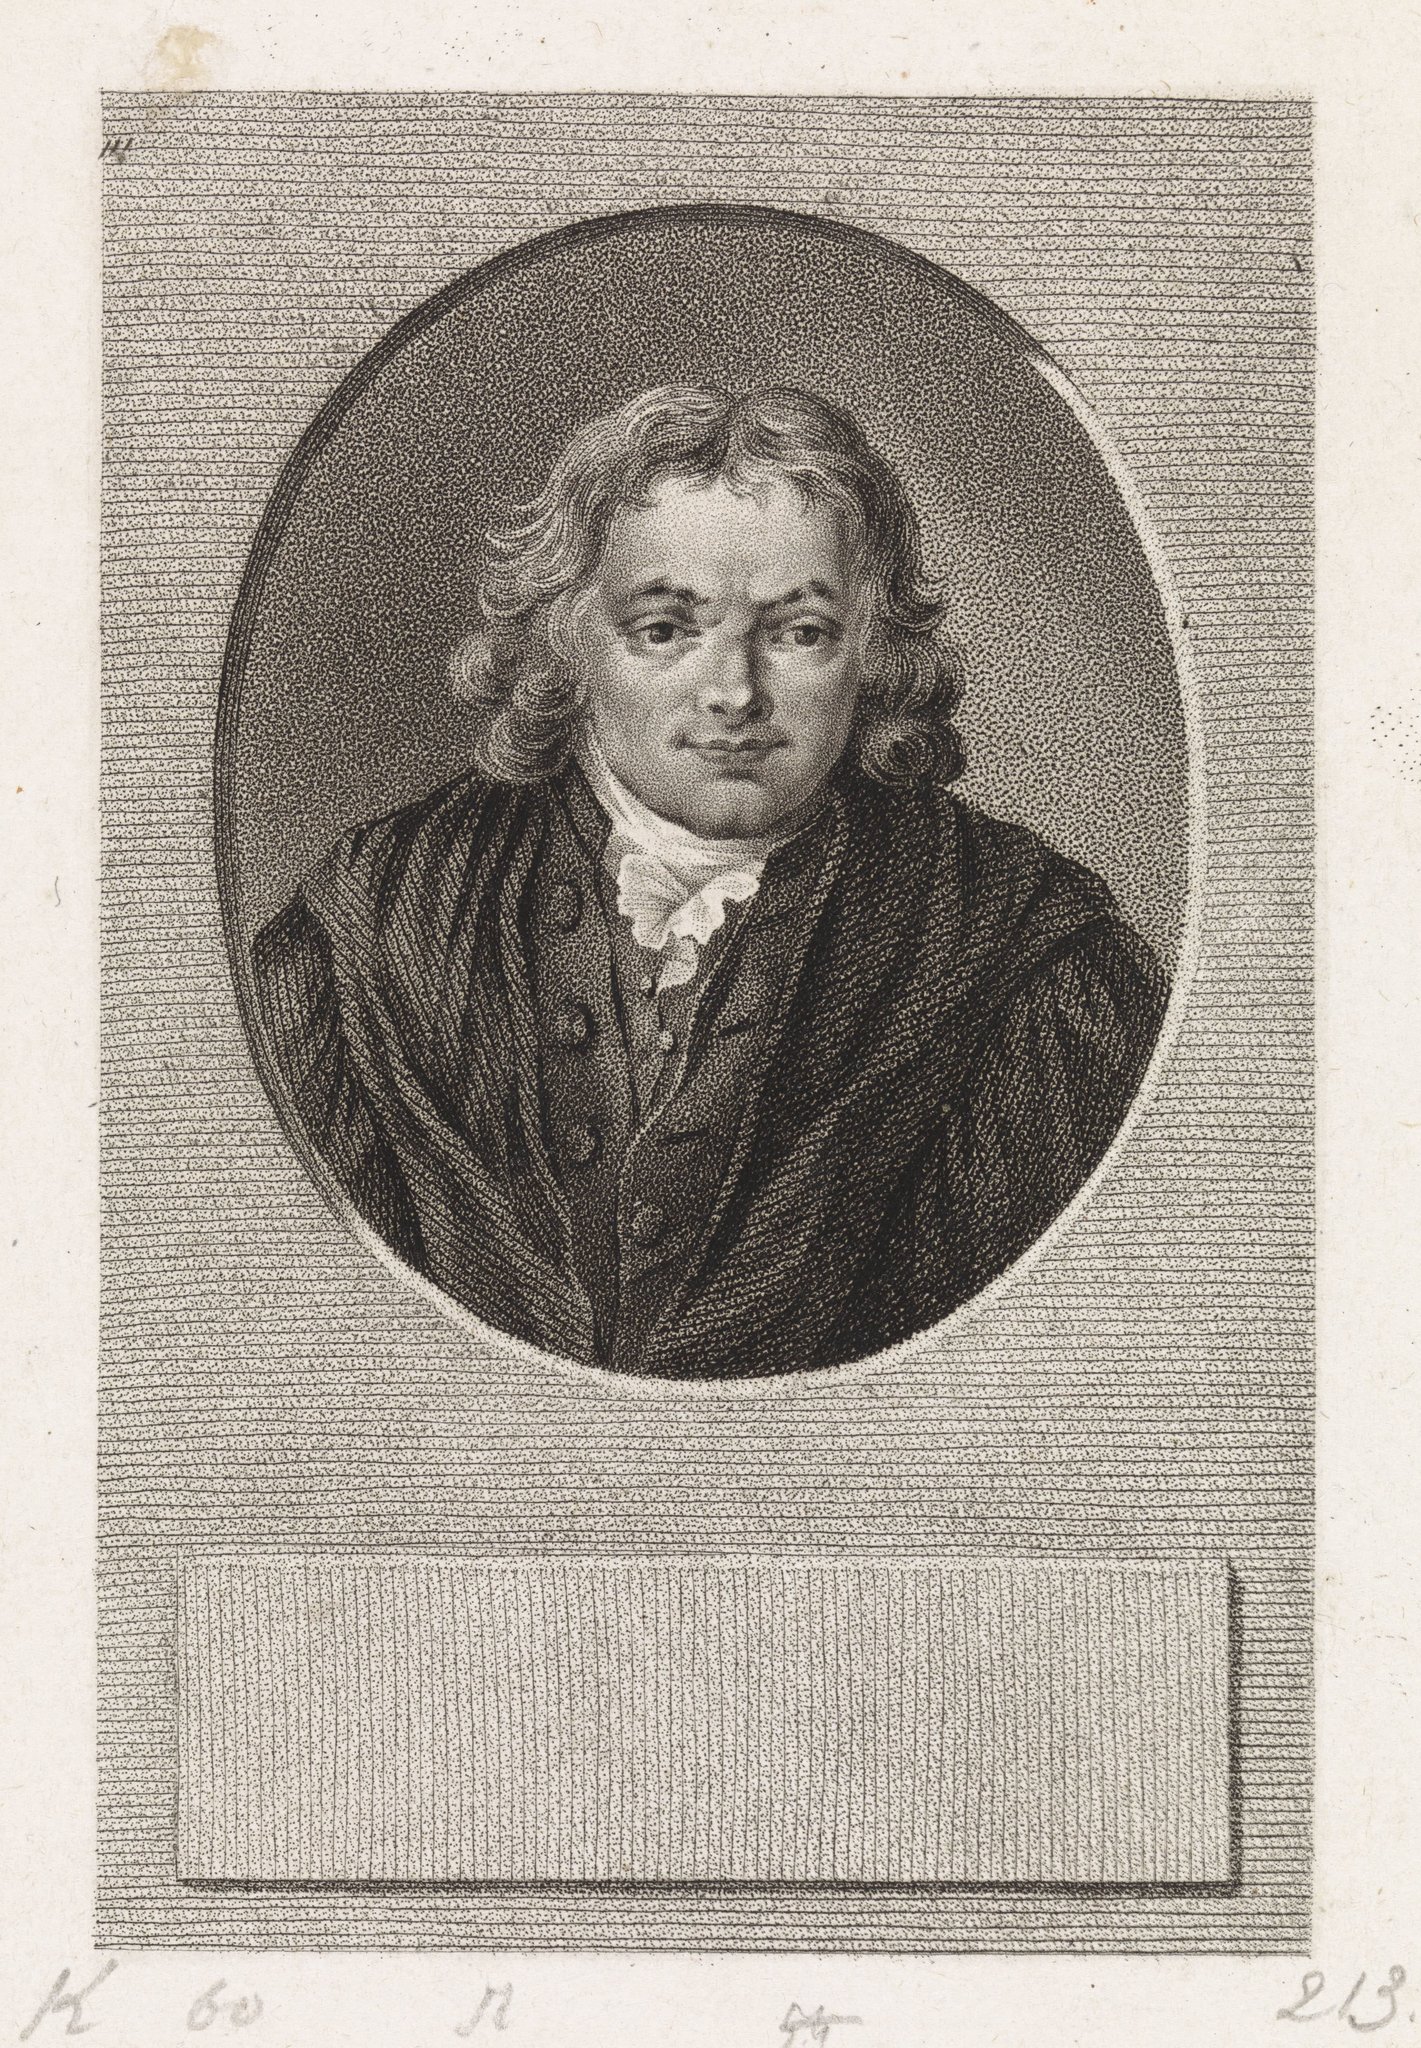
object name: print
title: Portret van hoogleraar Jean Luzac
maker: ludwig gottlieb portman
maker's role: print maker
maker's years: 1772-1828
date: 1787-1828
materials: paper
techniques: stippled etching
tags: leiden, publisher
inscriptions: collector's mark: Lugt 2228, number: ‘III’